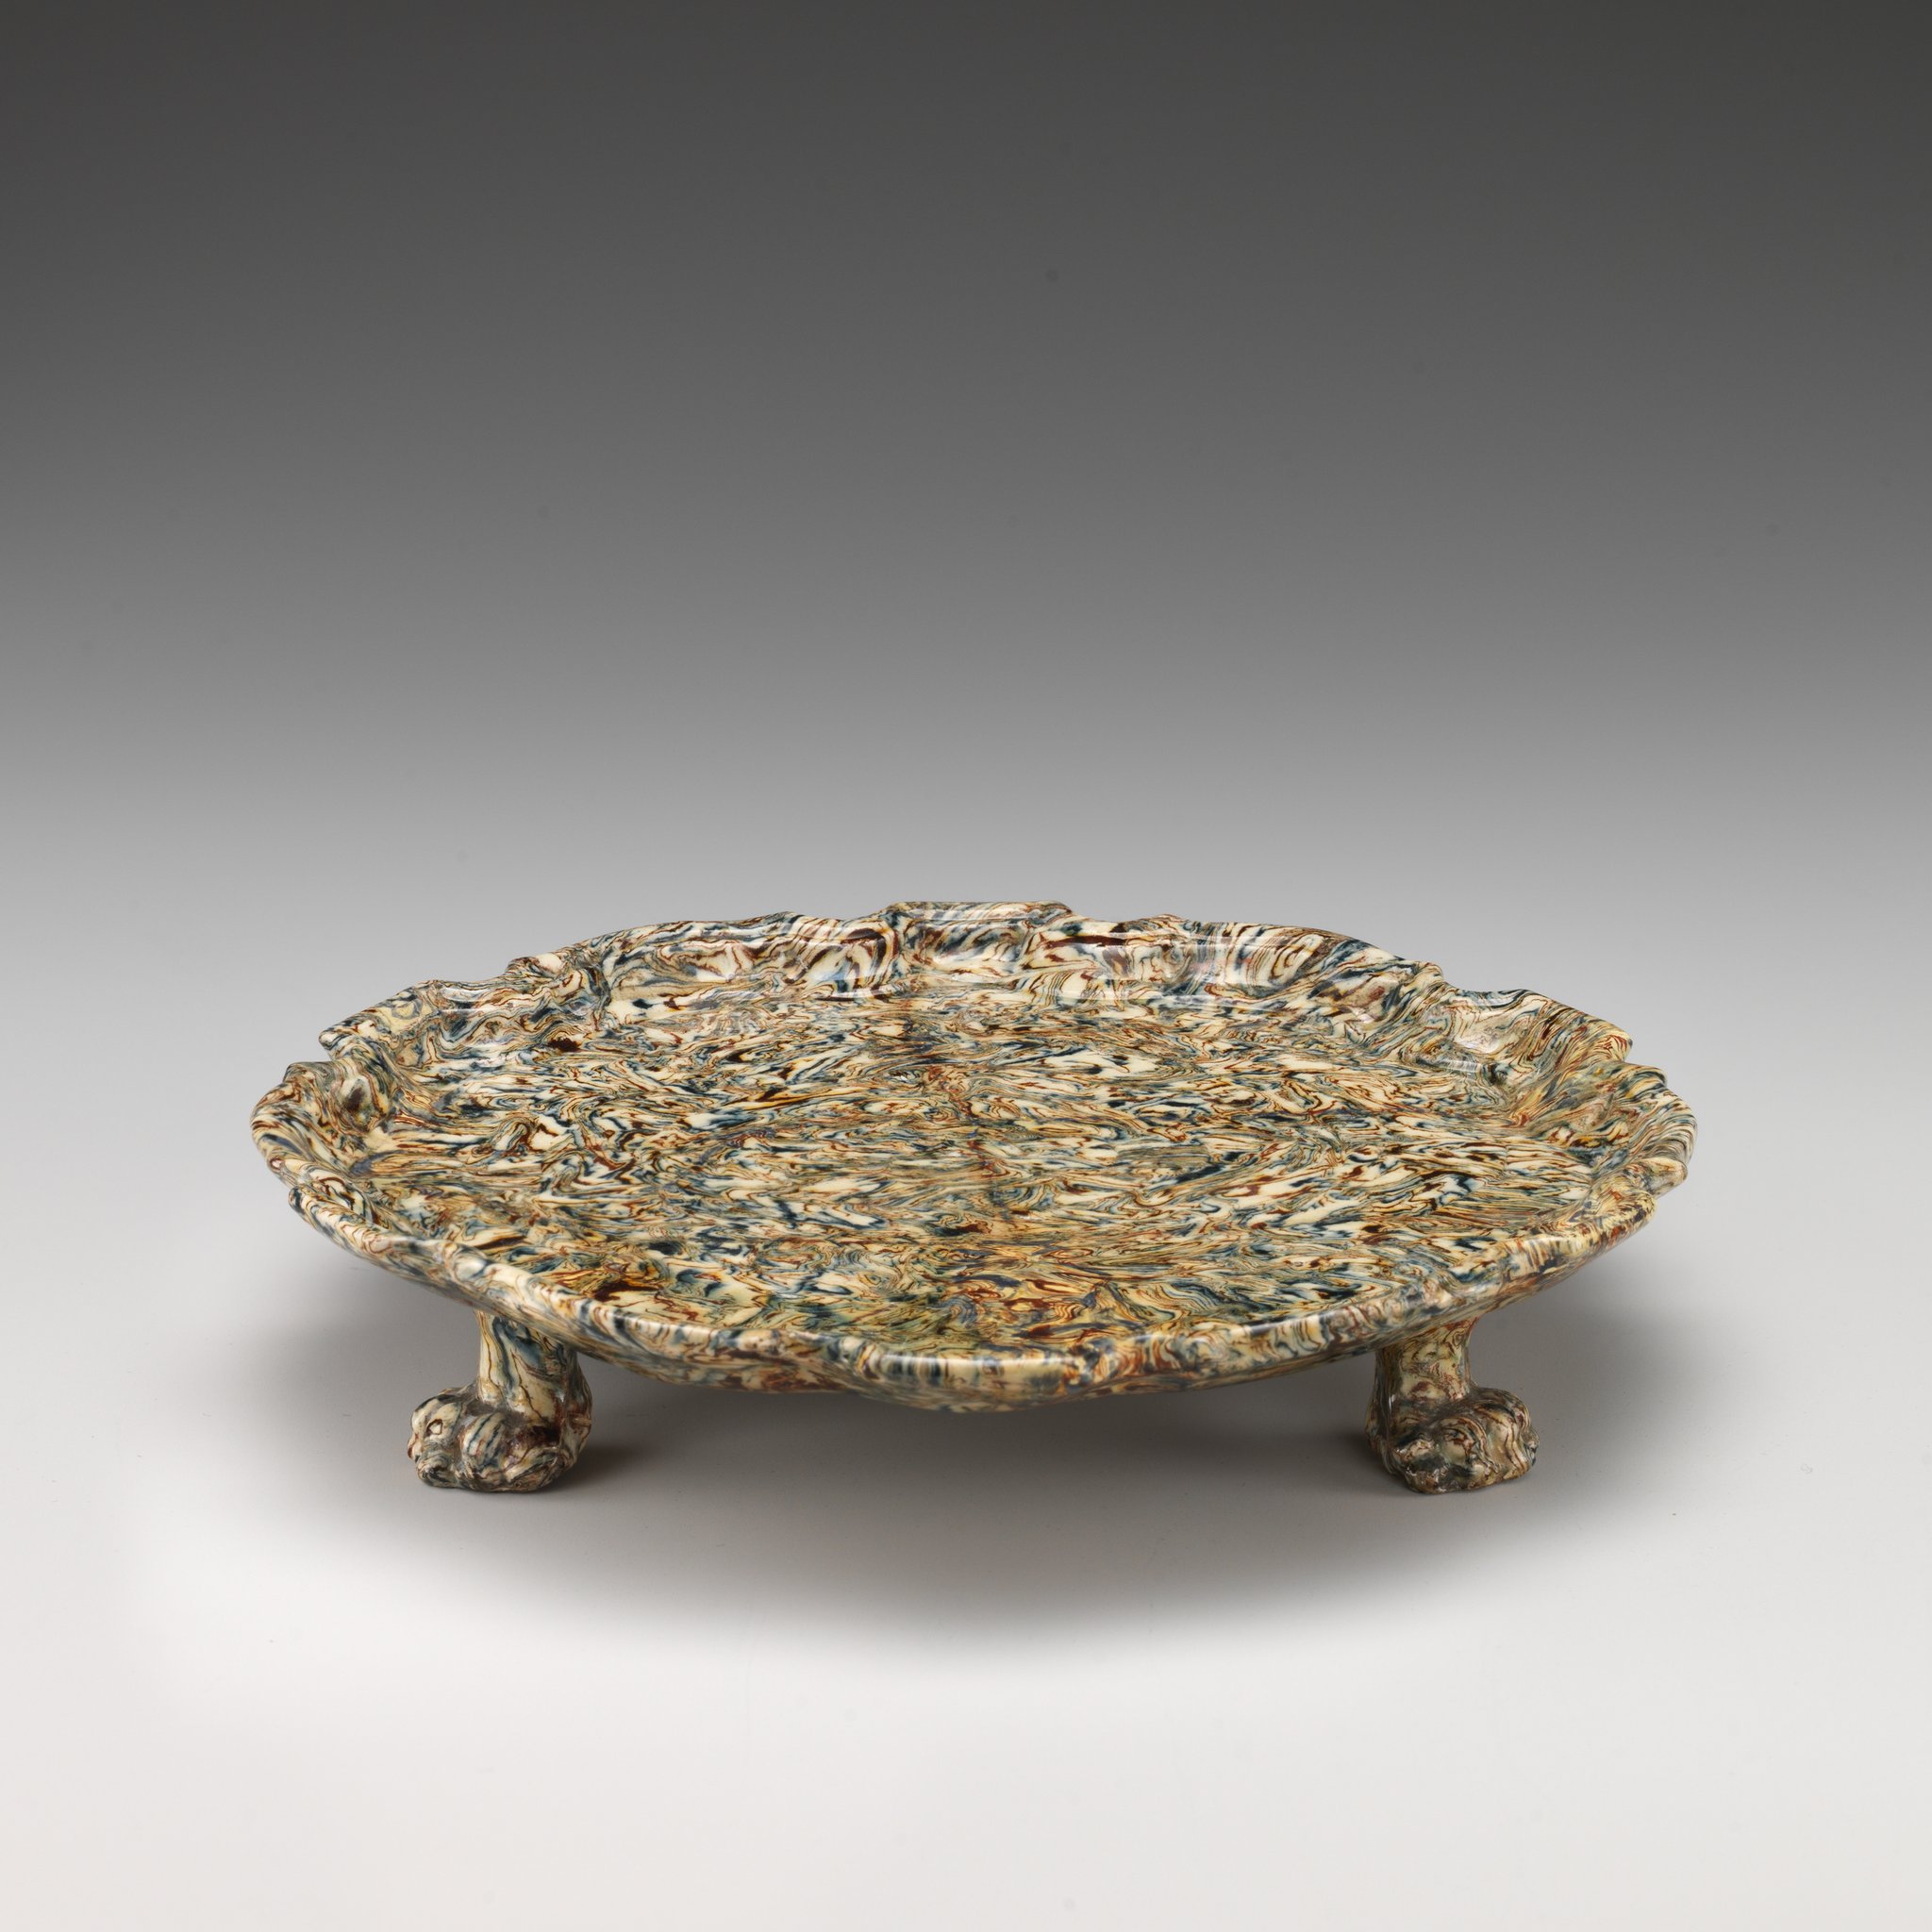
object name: teapot stand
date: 1745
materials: earthenware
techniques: glazing